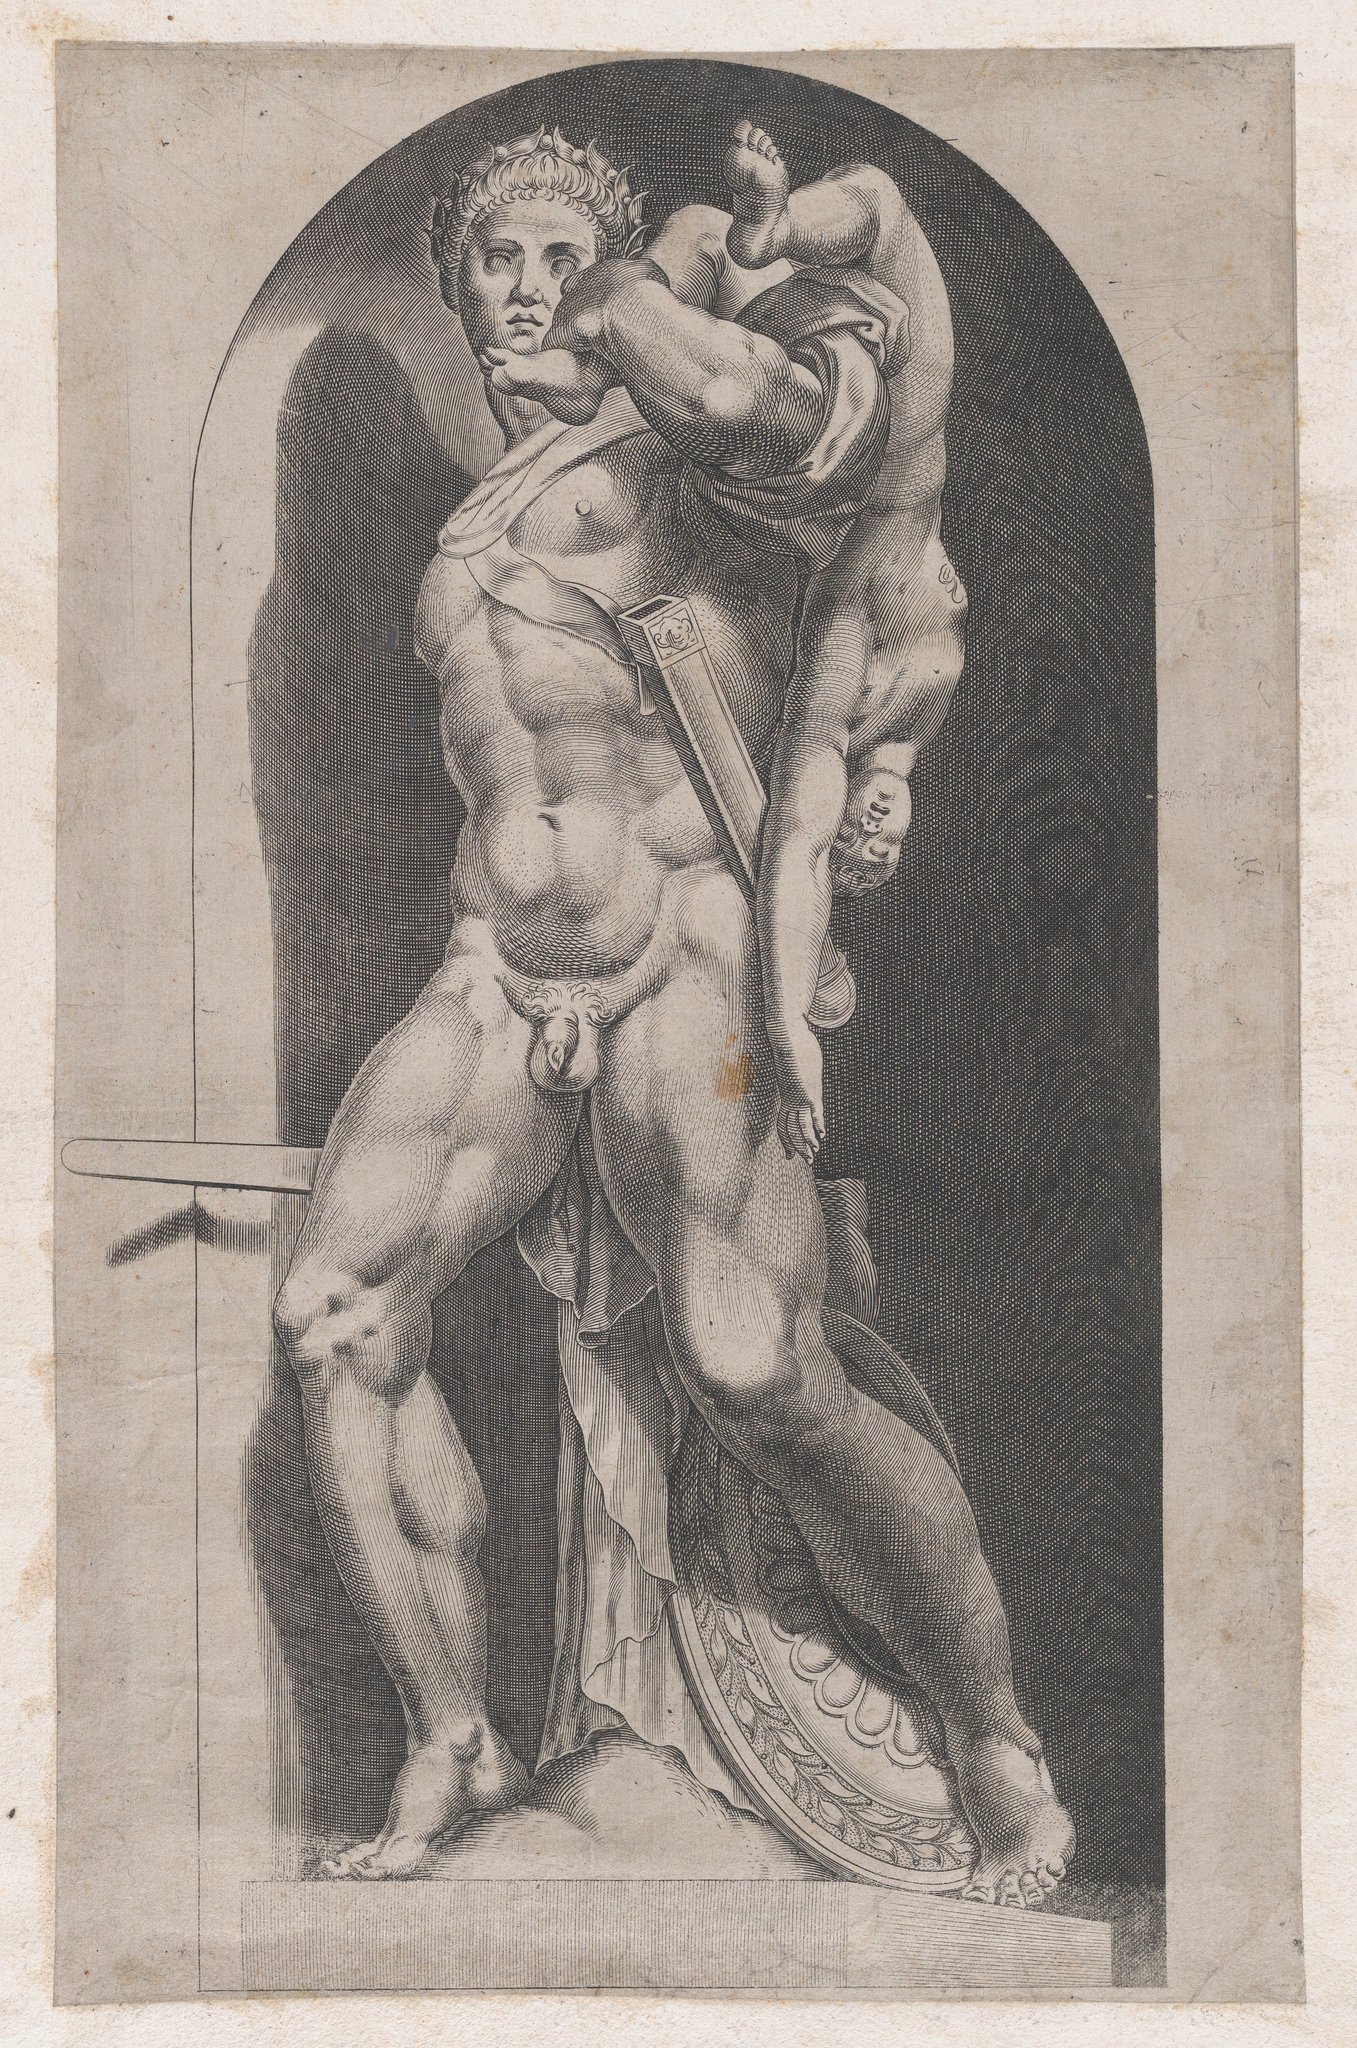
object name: print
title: Atreus Farnese, from "Speculum Romanae Magnificentiae"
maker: Anonymous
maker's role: artist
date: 1567-1600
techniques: engraving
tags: boys,male nudes